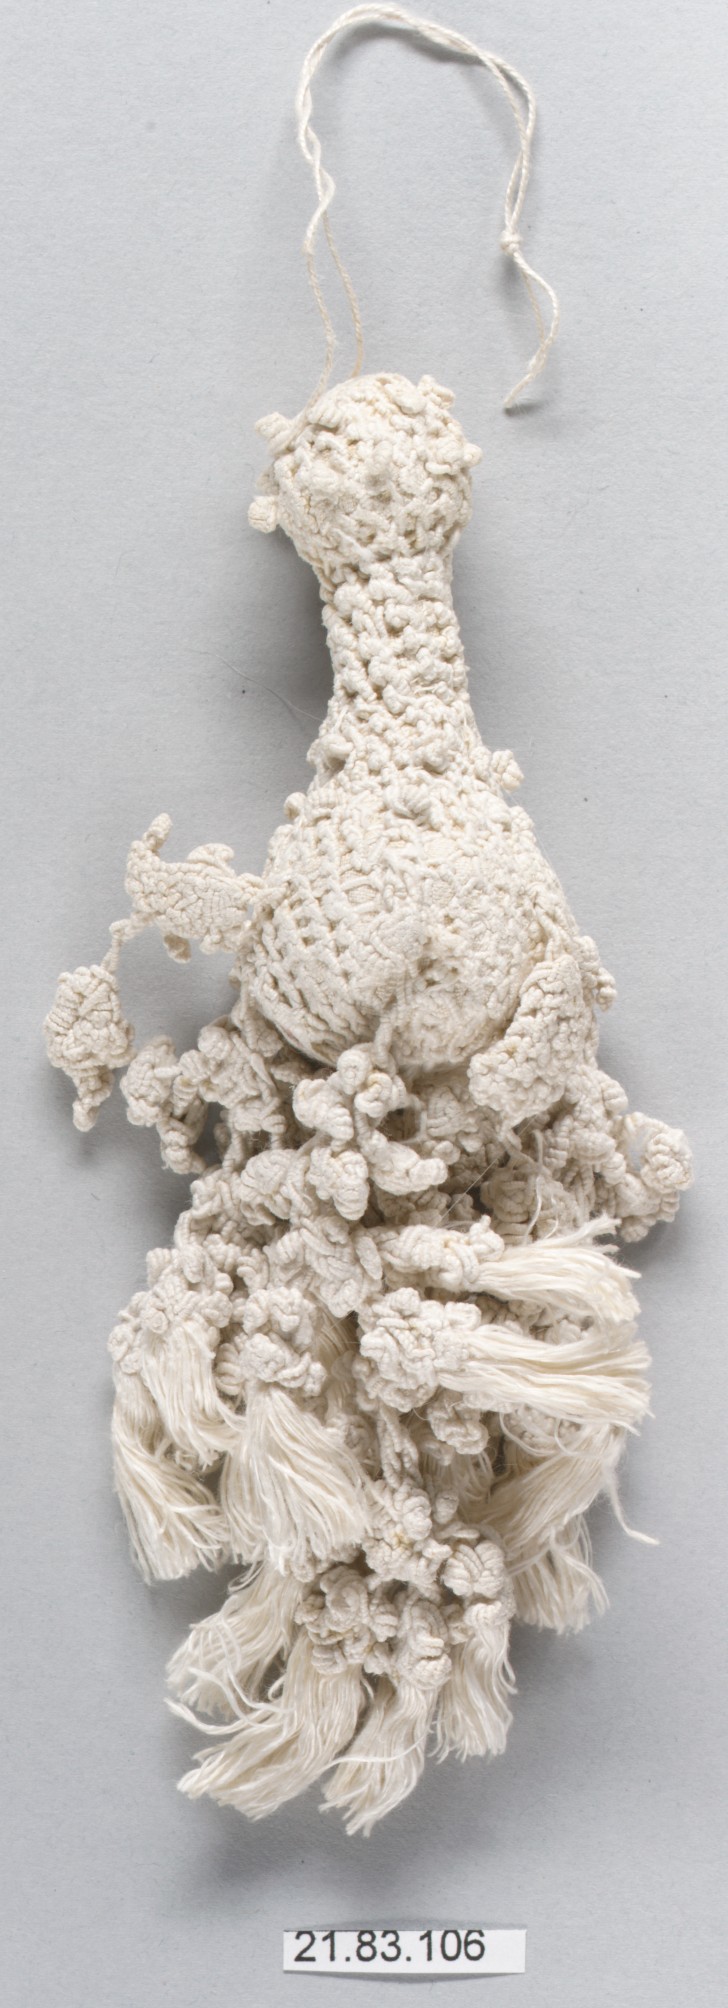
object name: tassel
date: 1601-1700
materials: linen